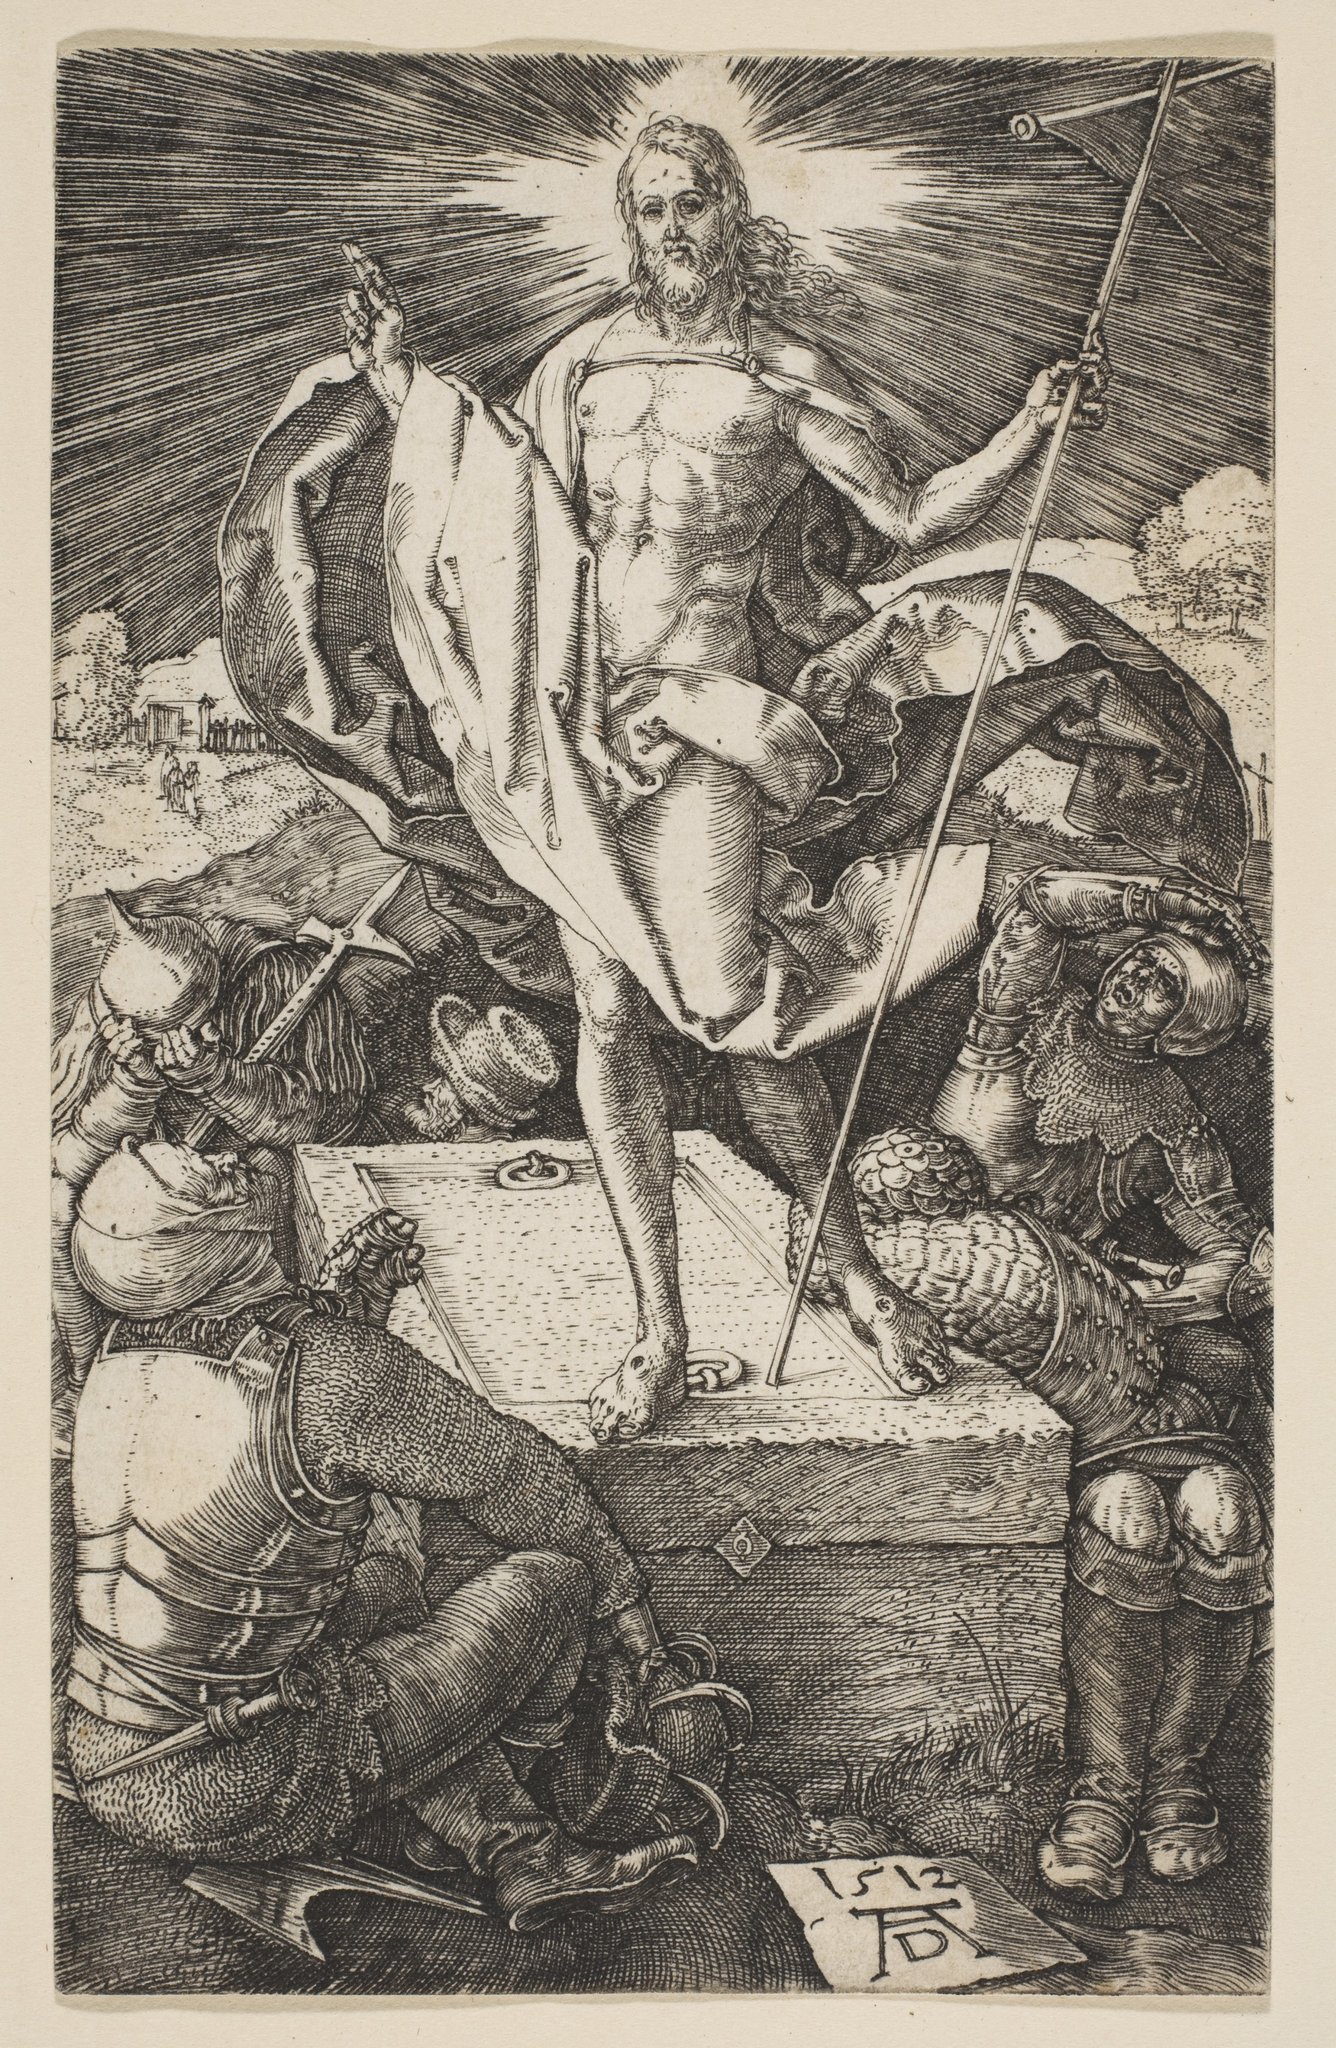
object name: print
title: The Resurrection, from "The Passion"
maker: albrecht dürer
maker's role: artist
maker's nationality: german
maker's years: 1471-1528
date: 1512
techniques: engraving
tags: soldiers,christ,resurrection